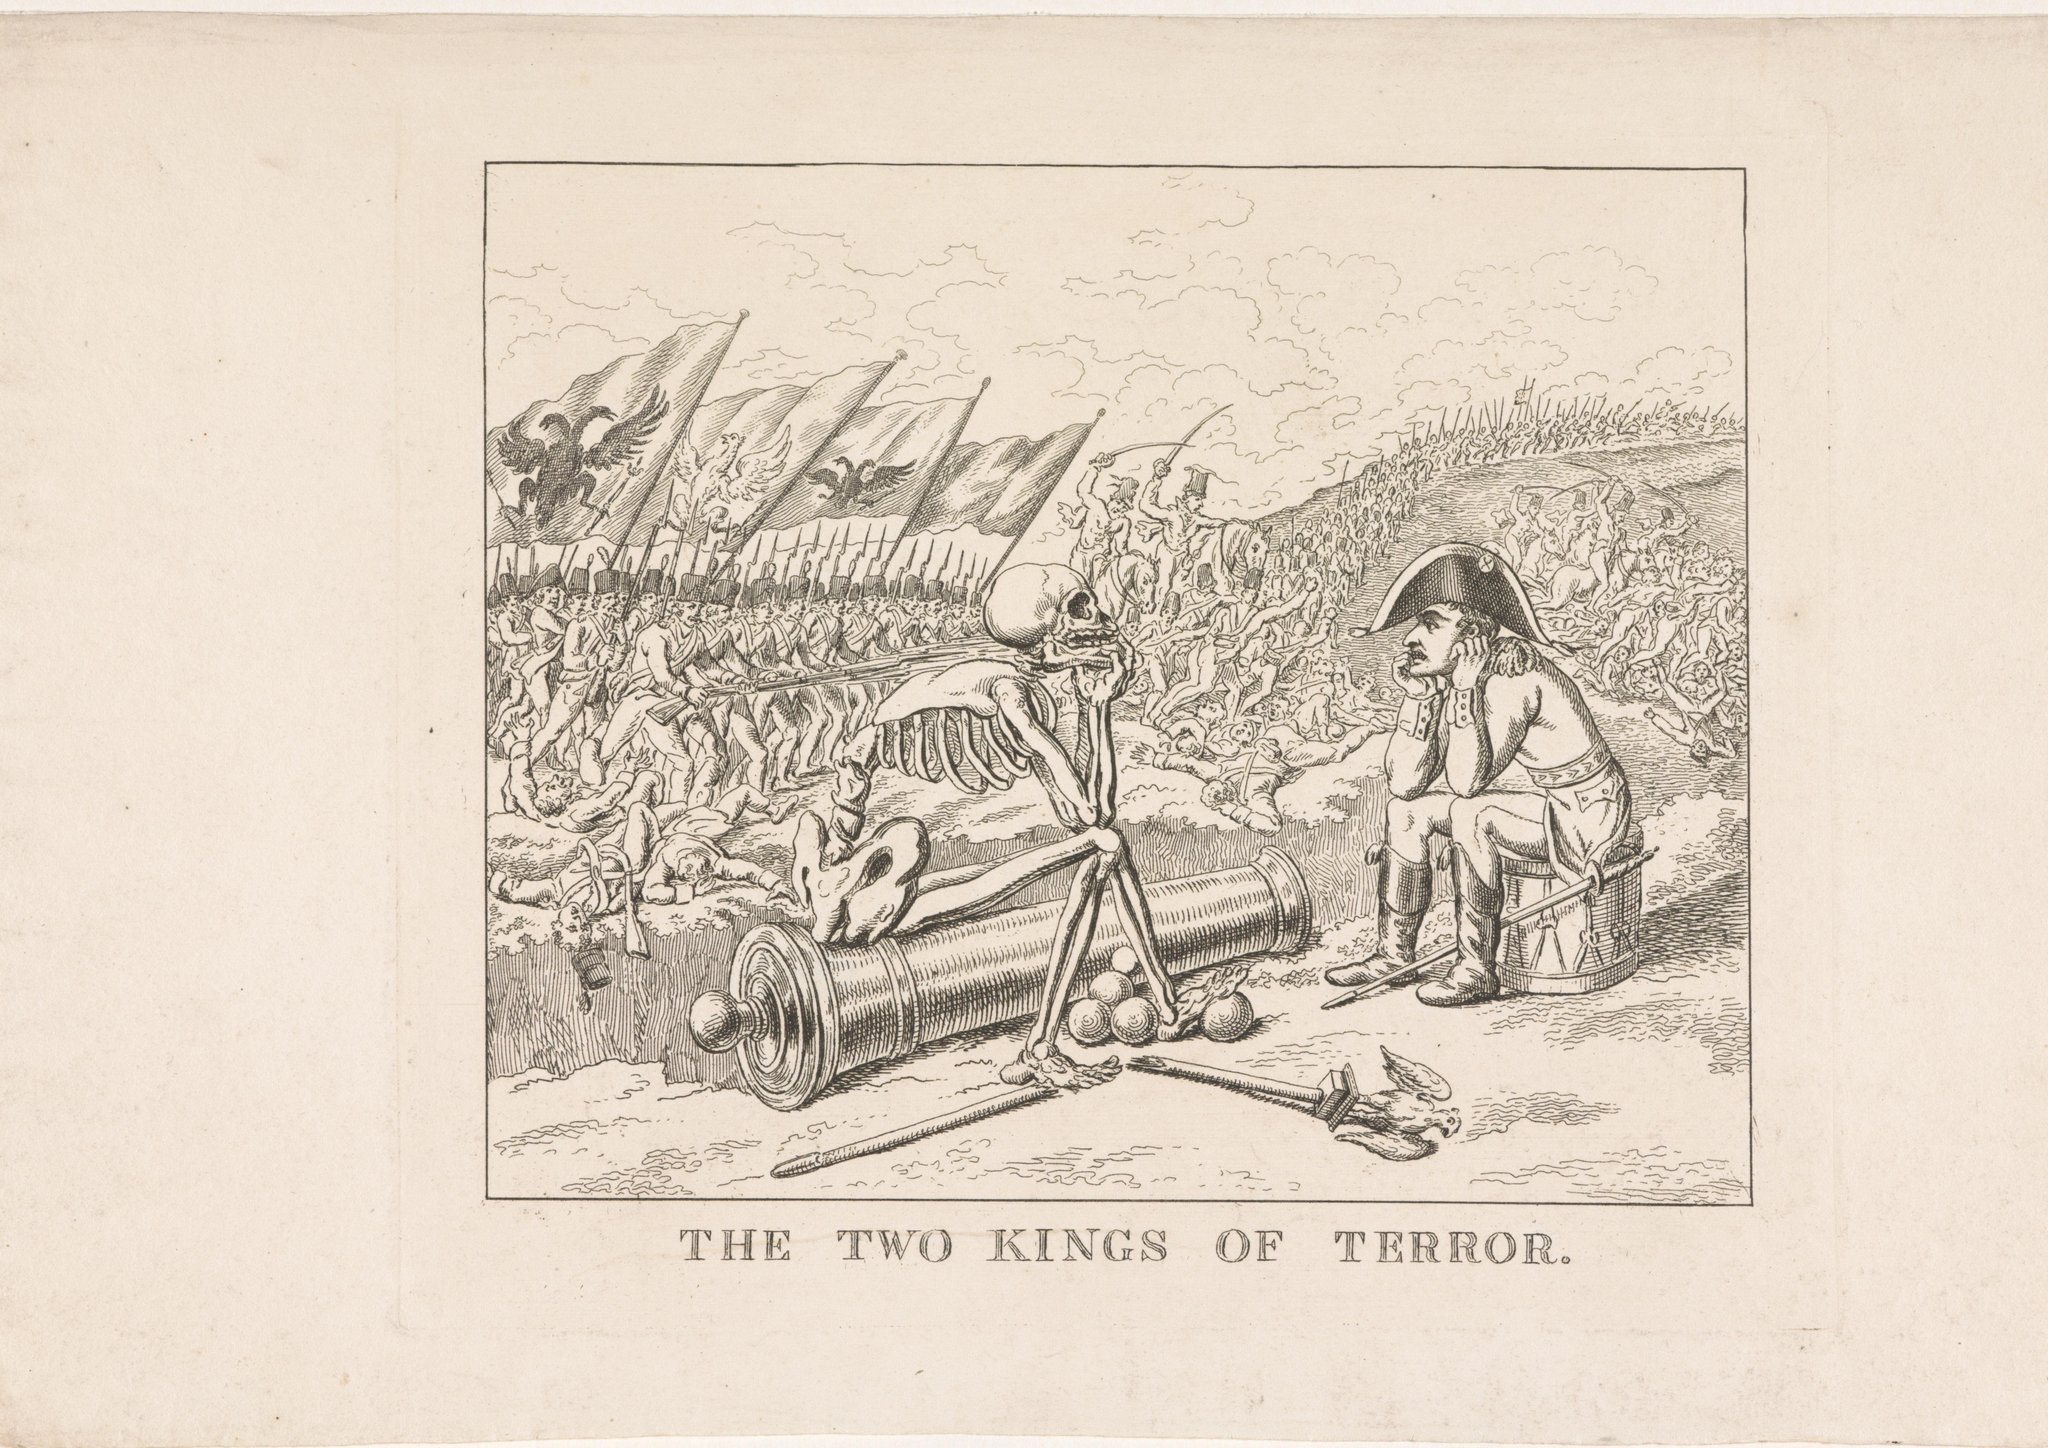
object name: cartoon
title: The Two Kings of Terror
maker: Anonymous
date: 1813-1814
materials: paper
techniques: etching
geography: netherlands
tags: napoleon i (emperor of the french), death as skeleton, battle (+ land forces)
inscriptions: collector's mark: Lugt 2228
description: Spotprent op Napoleon na de verloren slag bij Leipzig, 16-19 oktober 1813. Napoleon zittend op een trommel en de Dood als skelet, tegenover hem zittend op een kanon, beiden verslagen met de ellebogen op de knieën en het hoofd rustend in de handen. Het Franse veldteken met een adelaar ligt gebroken op de grond. Links de oprukkende troepen van de bondgenoten met de vlaggen van Pruisen, Rusland en Oostenrijk, rechts het vluchtende Franse leger. Bij de prent behoort een afzonderlijke verklaring.